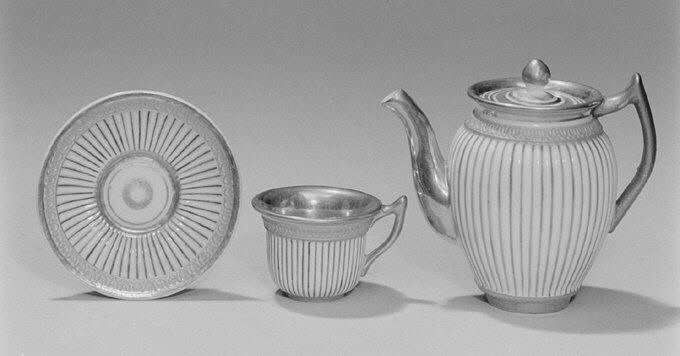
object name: tea and coffee set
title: Miniature tea and coffee set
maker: imperial porcelain manufactory, st. petersburg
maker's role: manufactory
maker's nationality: russian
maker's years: 1744-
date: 1825-1855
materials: hard paste porcelain